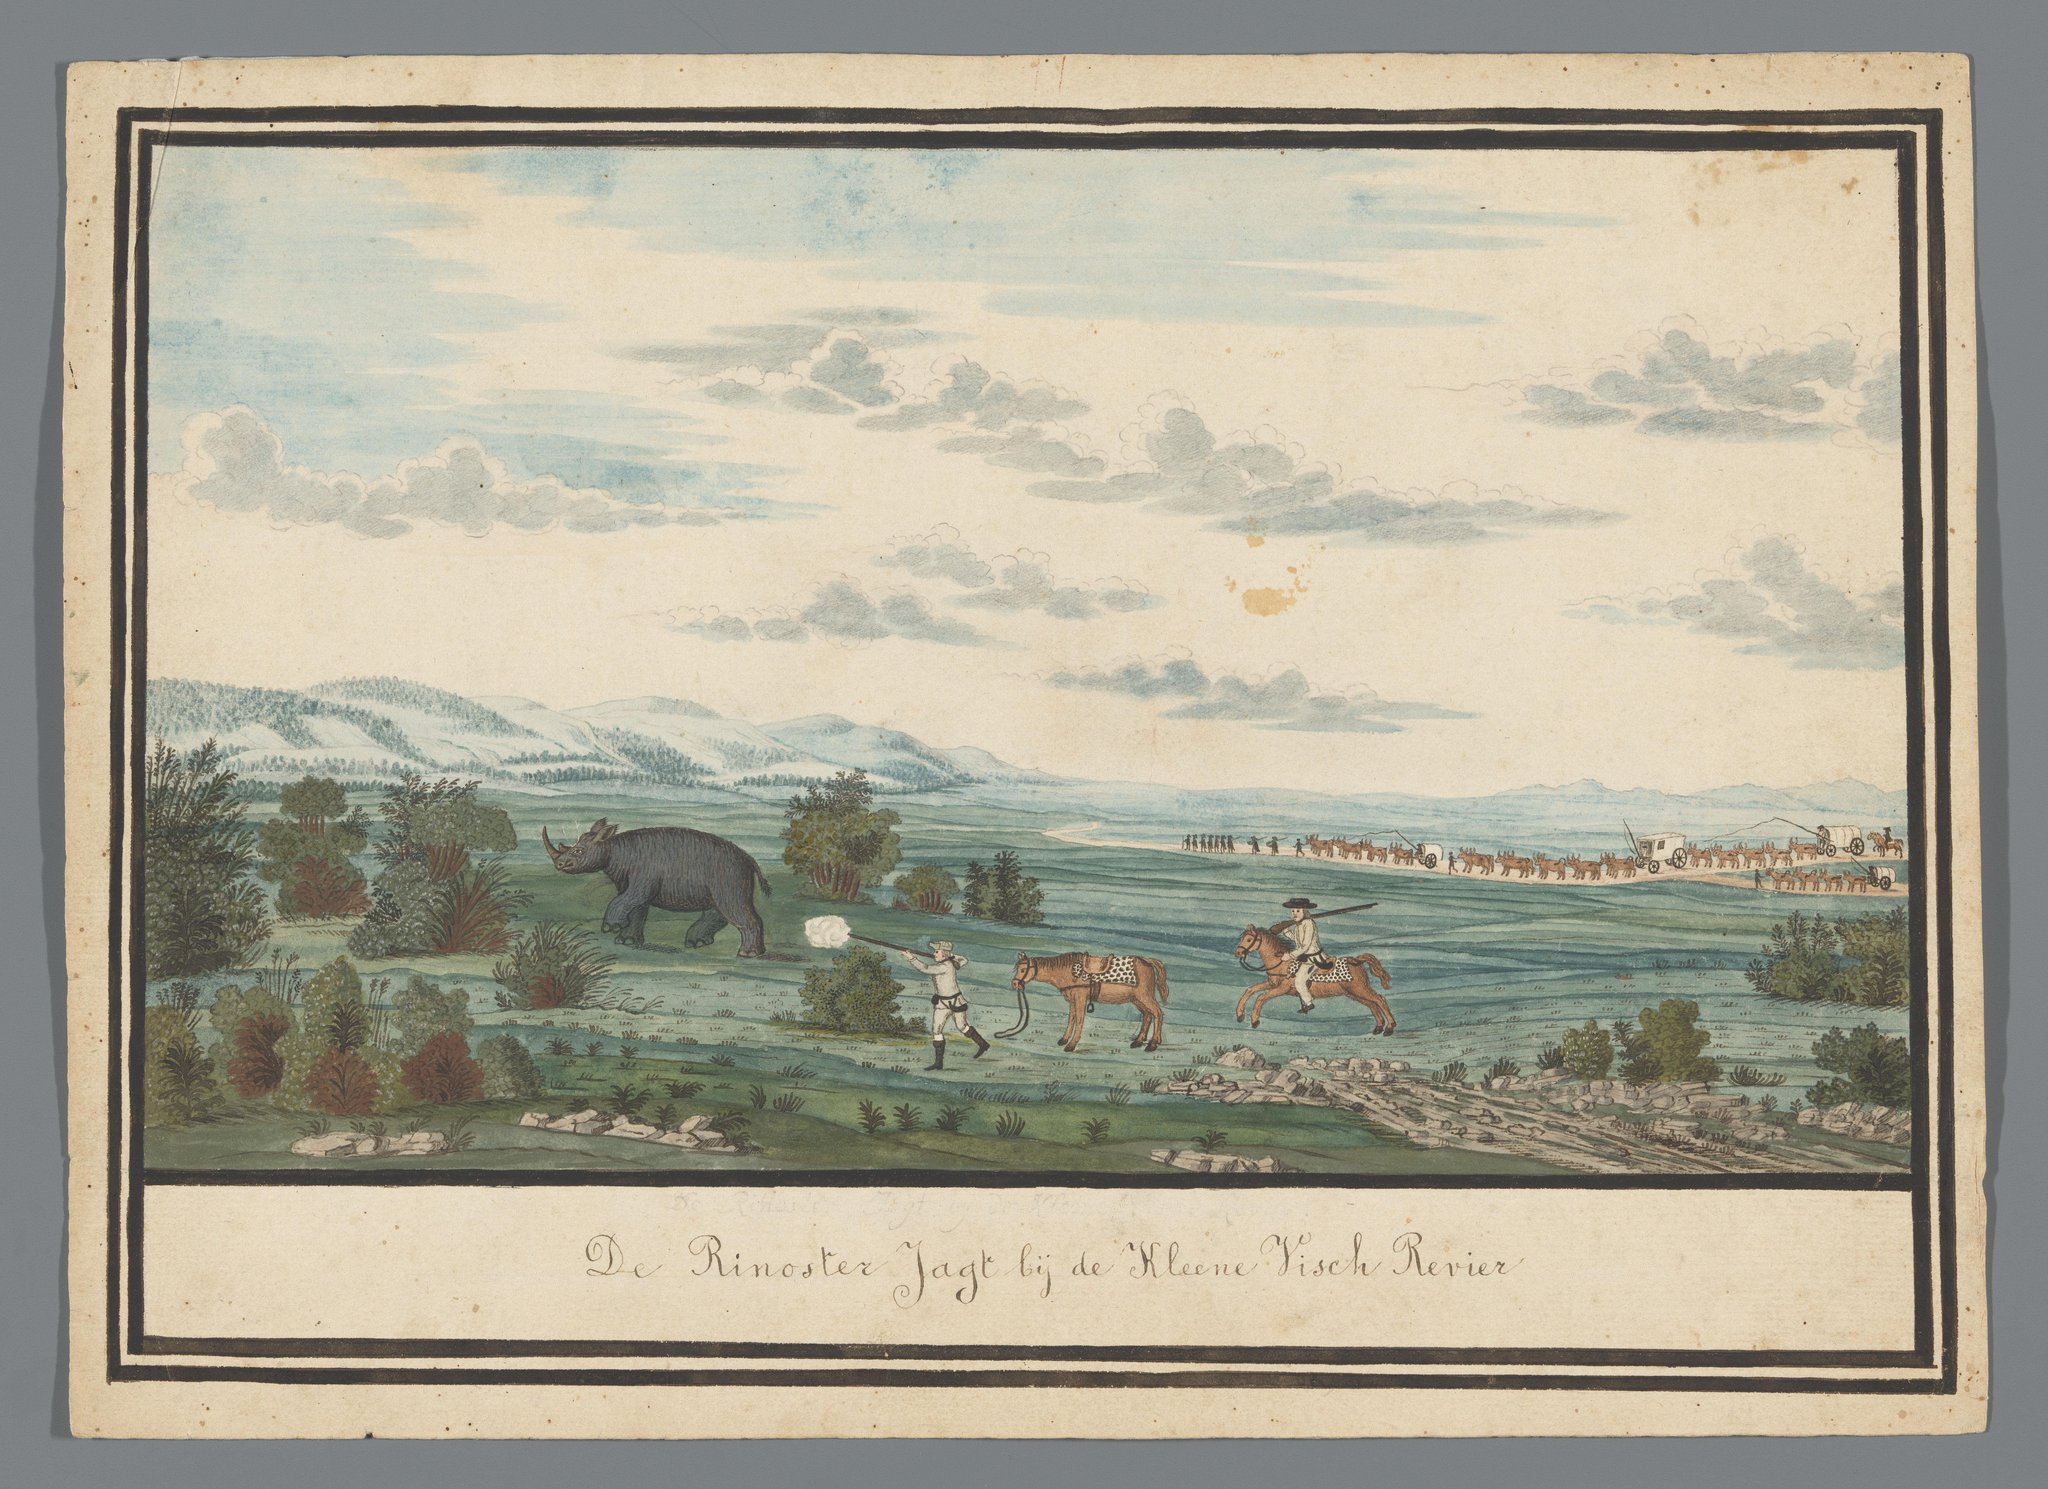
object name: drawing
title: De Rinoster Jagt bij de Kleene Visch Revier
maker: johannes schumacher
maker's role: draughtsman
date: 1711-1776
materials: paper, watercolor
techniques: brush, pen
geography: south africa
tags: cape of good hope, hoofed animals: rhinoceros (+ animal killed by man), little fish river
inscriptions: label: ‘21’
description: Jacht op een neushoorn bij de Klein Visrivier (Little Fish River). De neushoorn wordt geschoten door Pieter Cloete. Op de achtergrond de ossenwagens van het reisgezelschap. Tekening gemaakt tijdens de tweede reis van Hendrik Swellengrebel, naar het noordoosten van de Kaapkolonie, 10 september - 26 december 1776. Volgens het reisjournaal wordt de neushoorn door Cloete gedood op 1 november 1776.